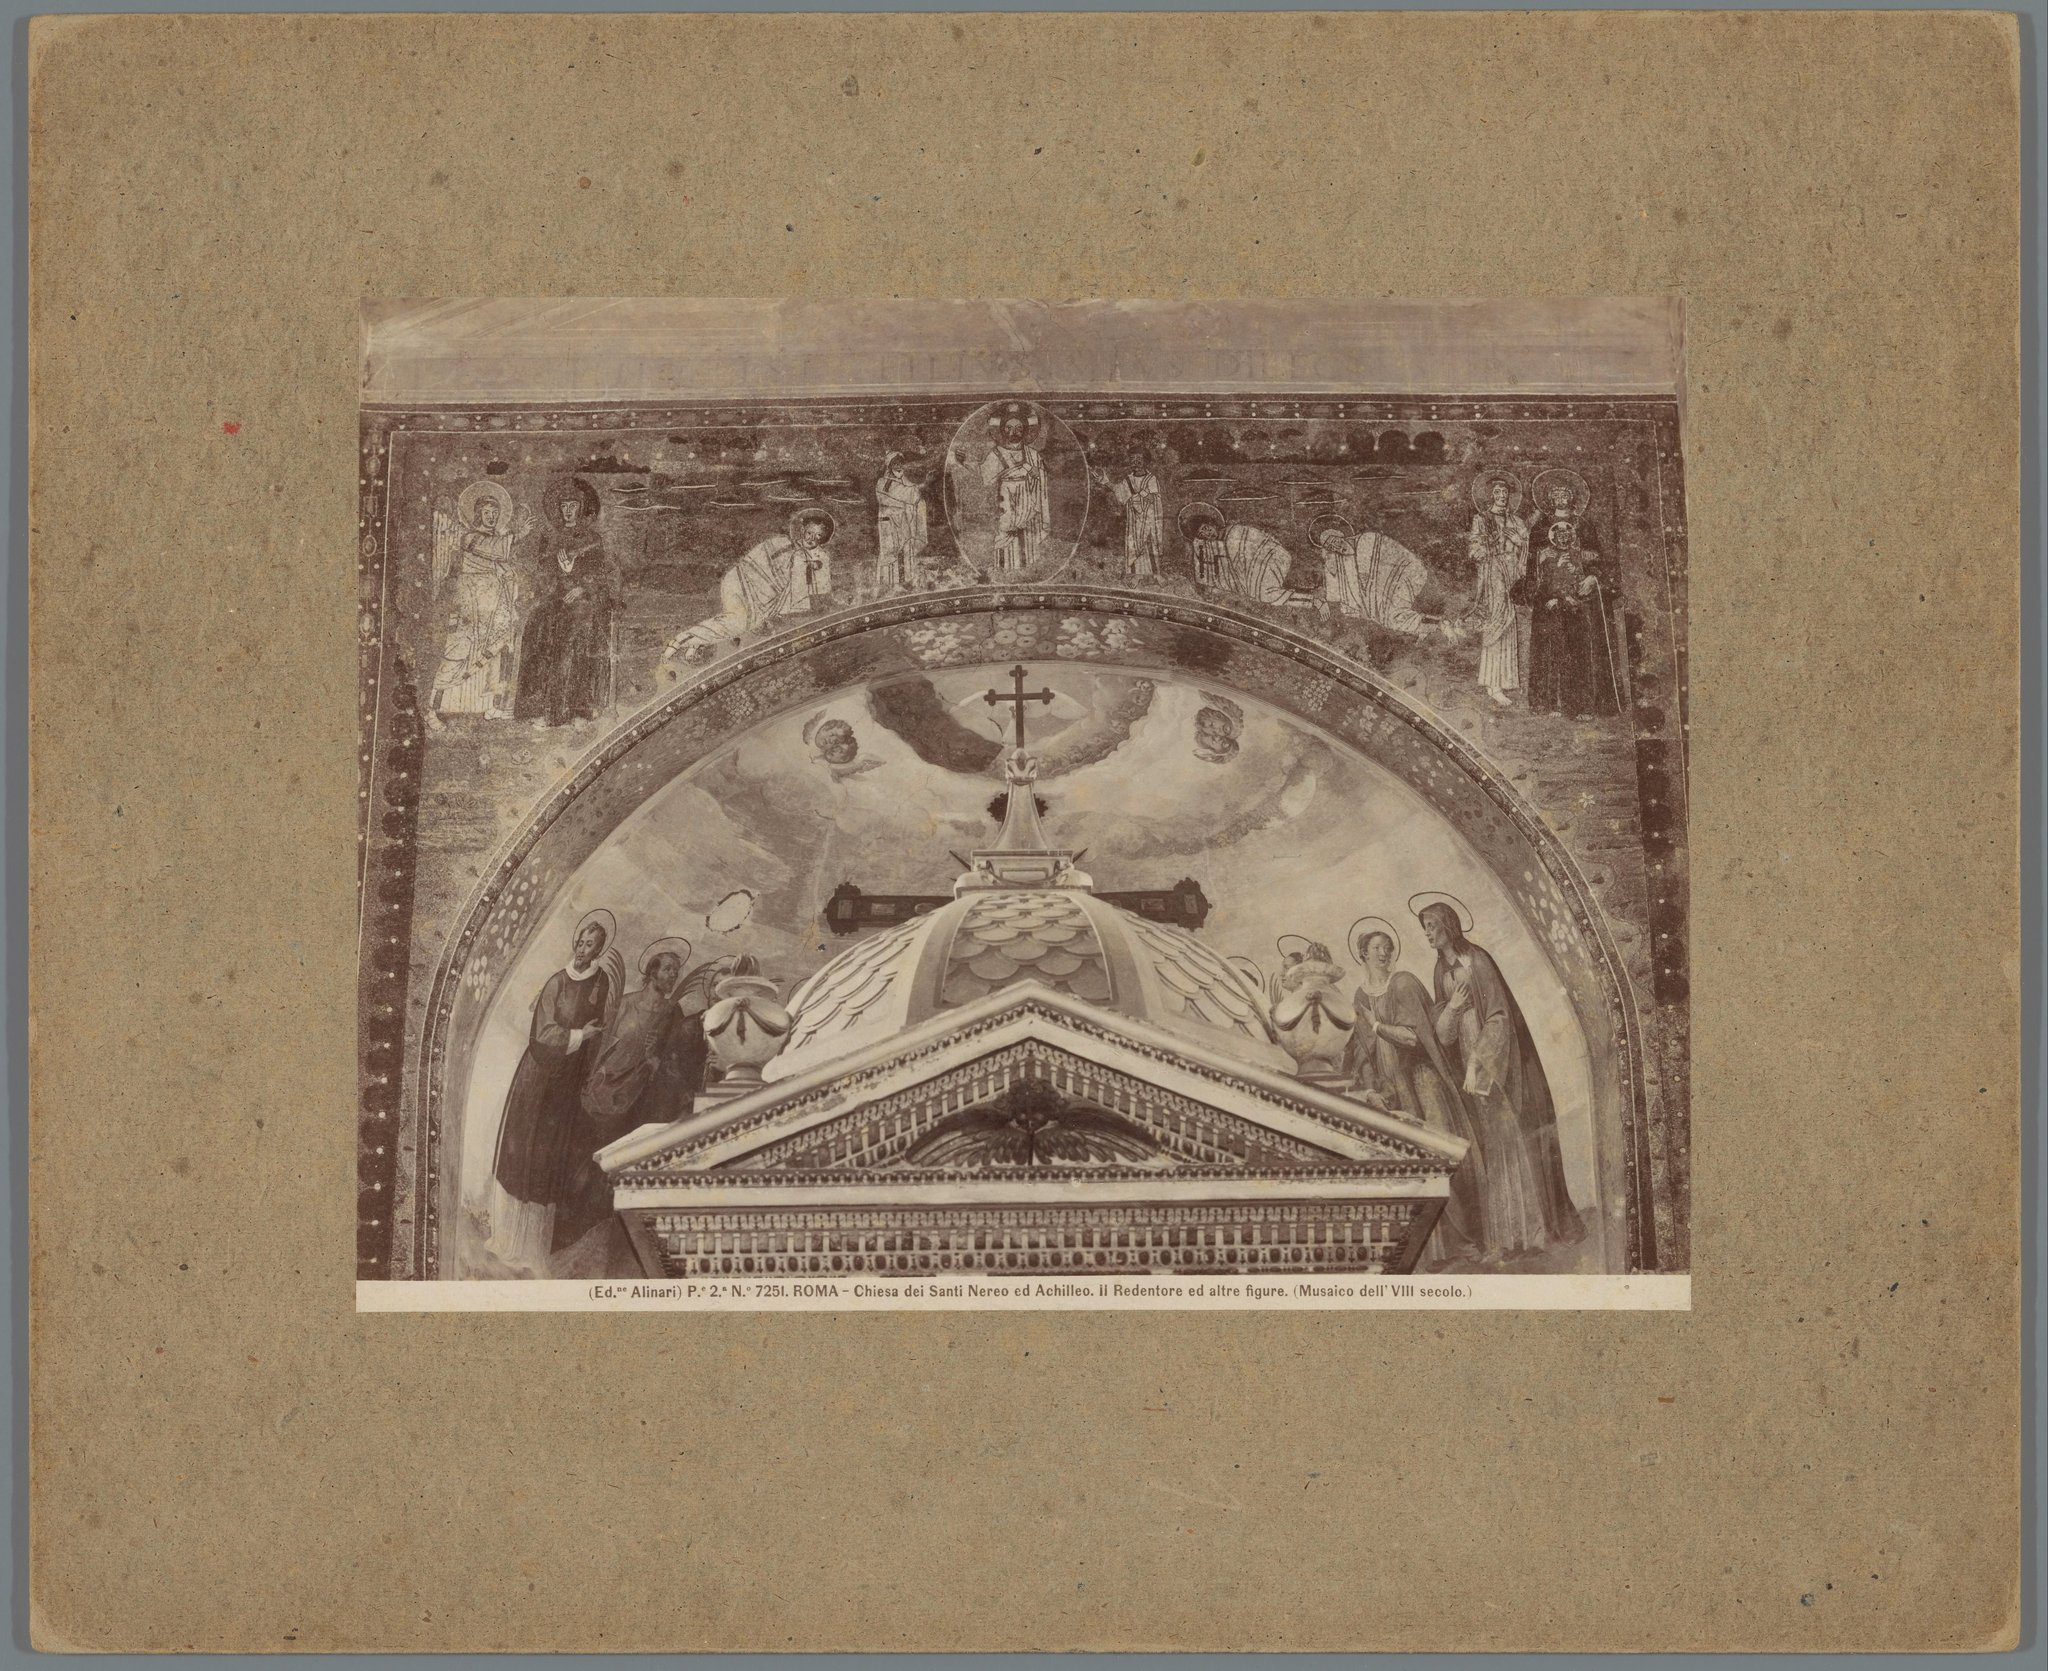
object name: photograph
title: Mozaïek van het hoofdaltaar van de Santi Nereo e Achilleo te Rome, voorstellend Christus en verschillende heiligen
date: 1875-1900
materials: cardboard, photographic support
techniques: albumen print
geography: santi nereo e achilleo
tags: altar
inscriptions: collector's mark: Lugt 3937, inscription: ‘S.K. 2.’, number: ‘P.e 2.a N.o 7251.’